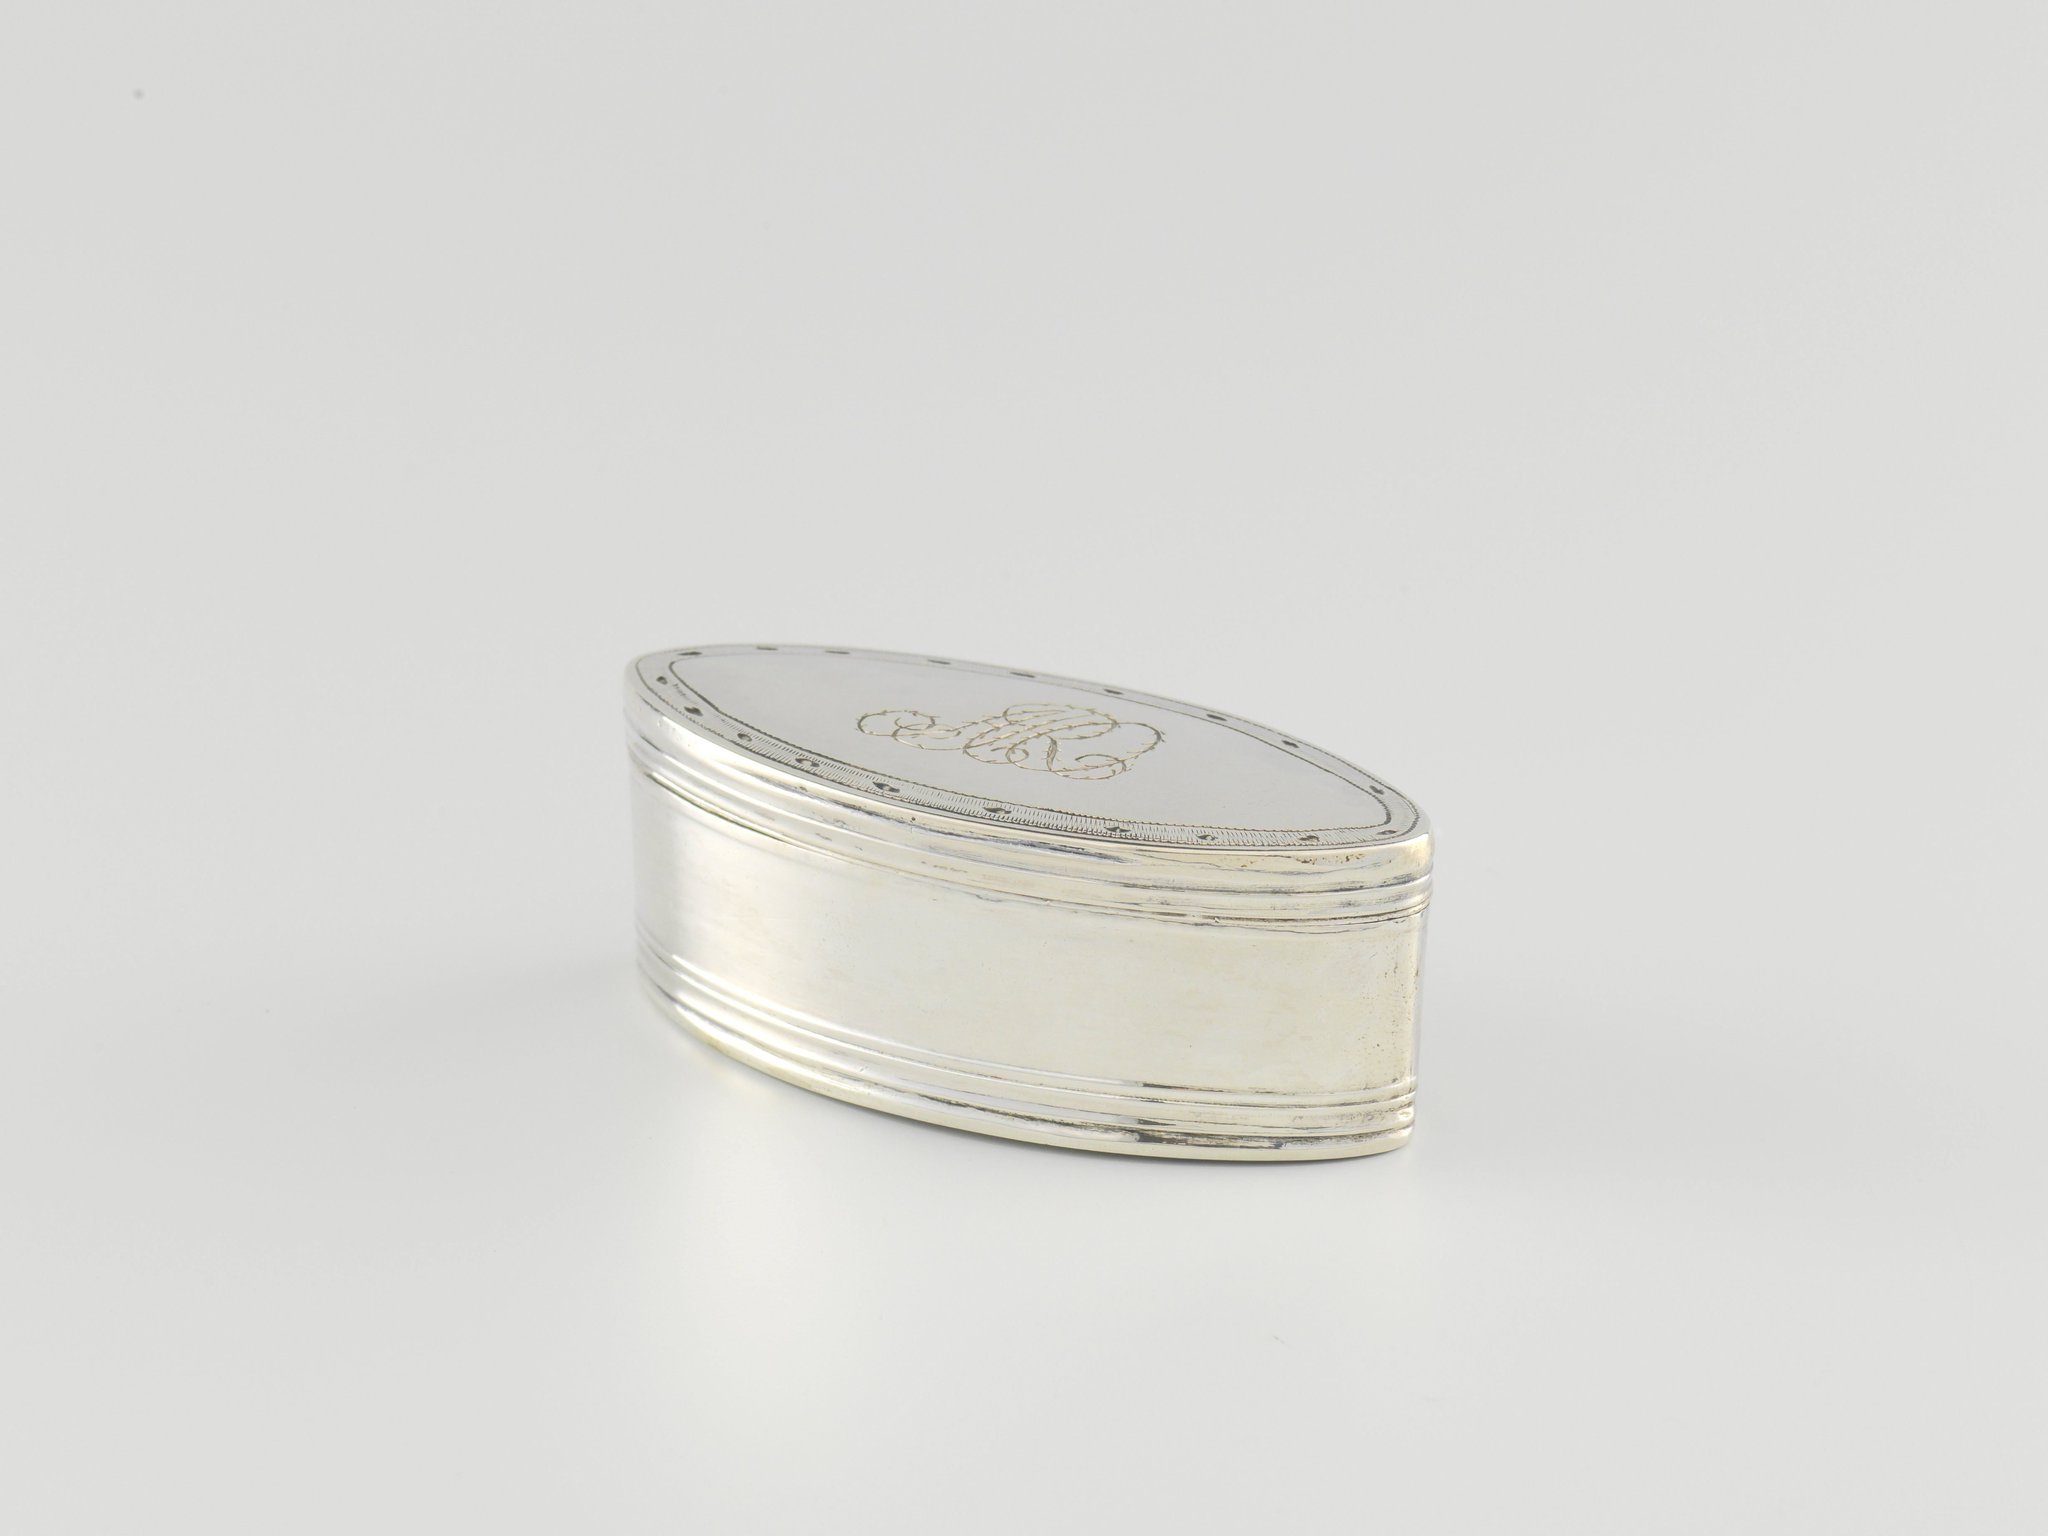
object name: snuffbox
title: Snuifdoos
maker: Anonymous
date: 1801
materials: silver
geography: schoonhoven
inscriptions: mark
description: Spitsovale snuifdoos van zilver, met een vlam, scharnierend deksel. Op het deksel is een monogram van de letters A R O gegraveerd binnen een rand met geometrische motieven.